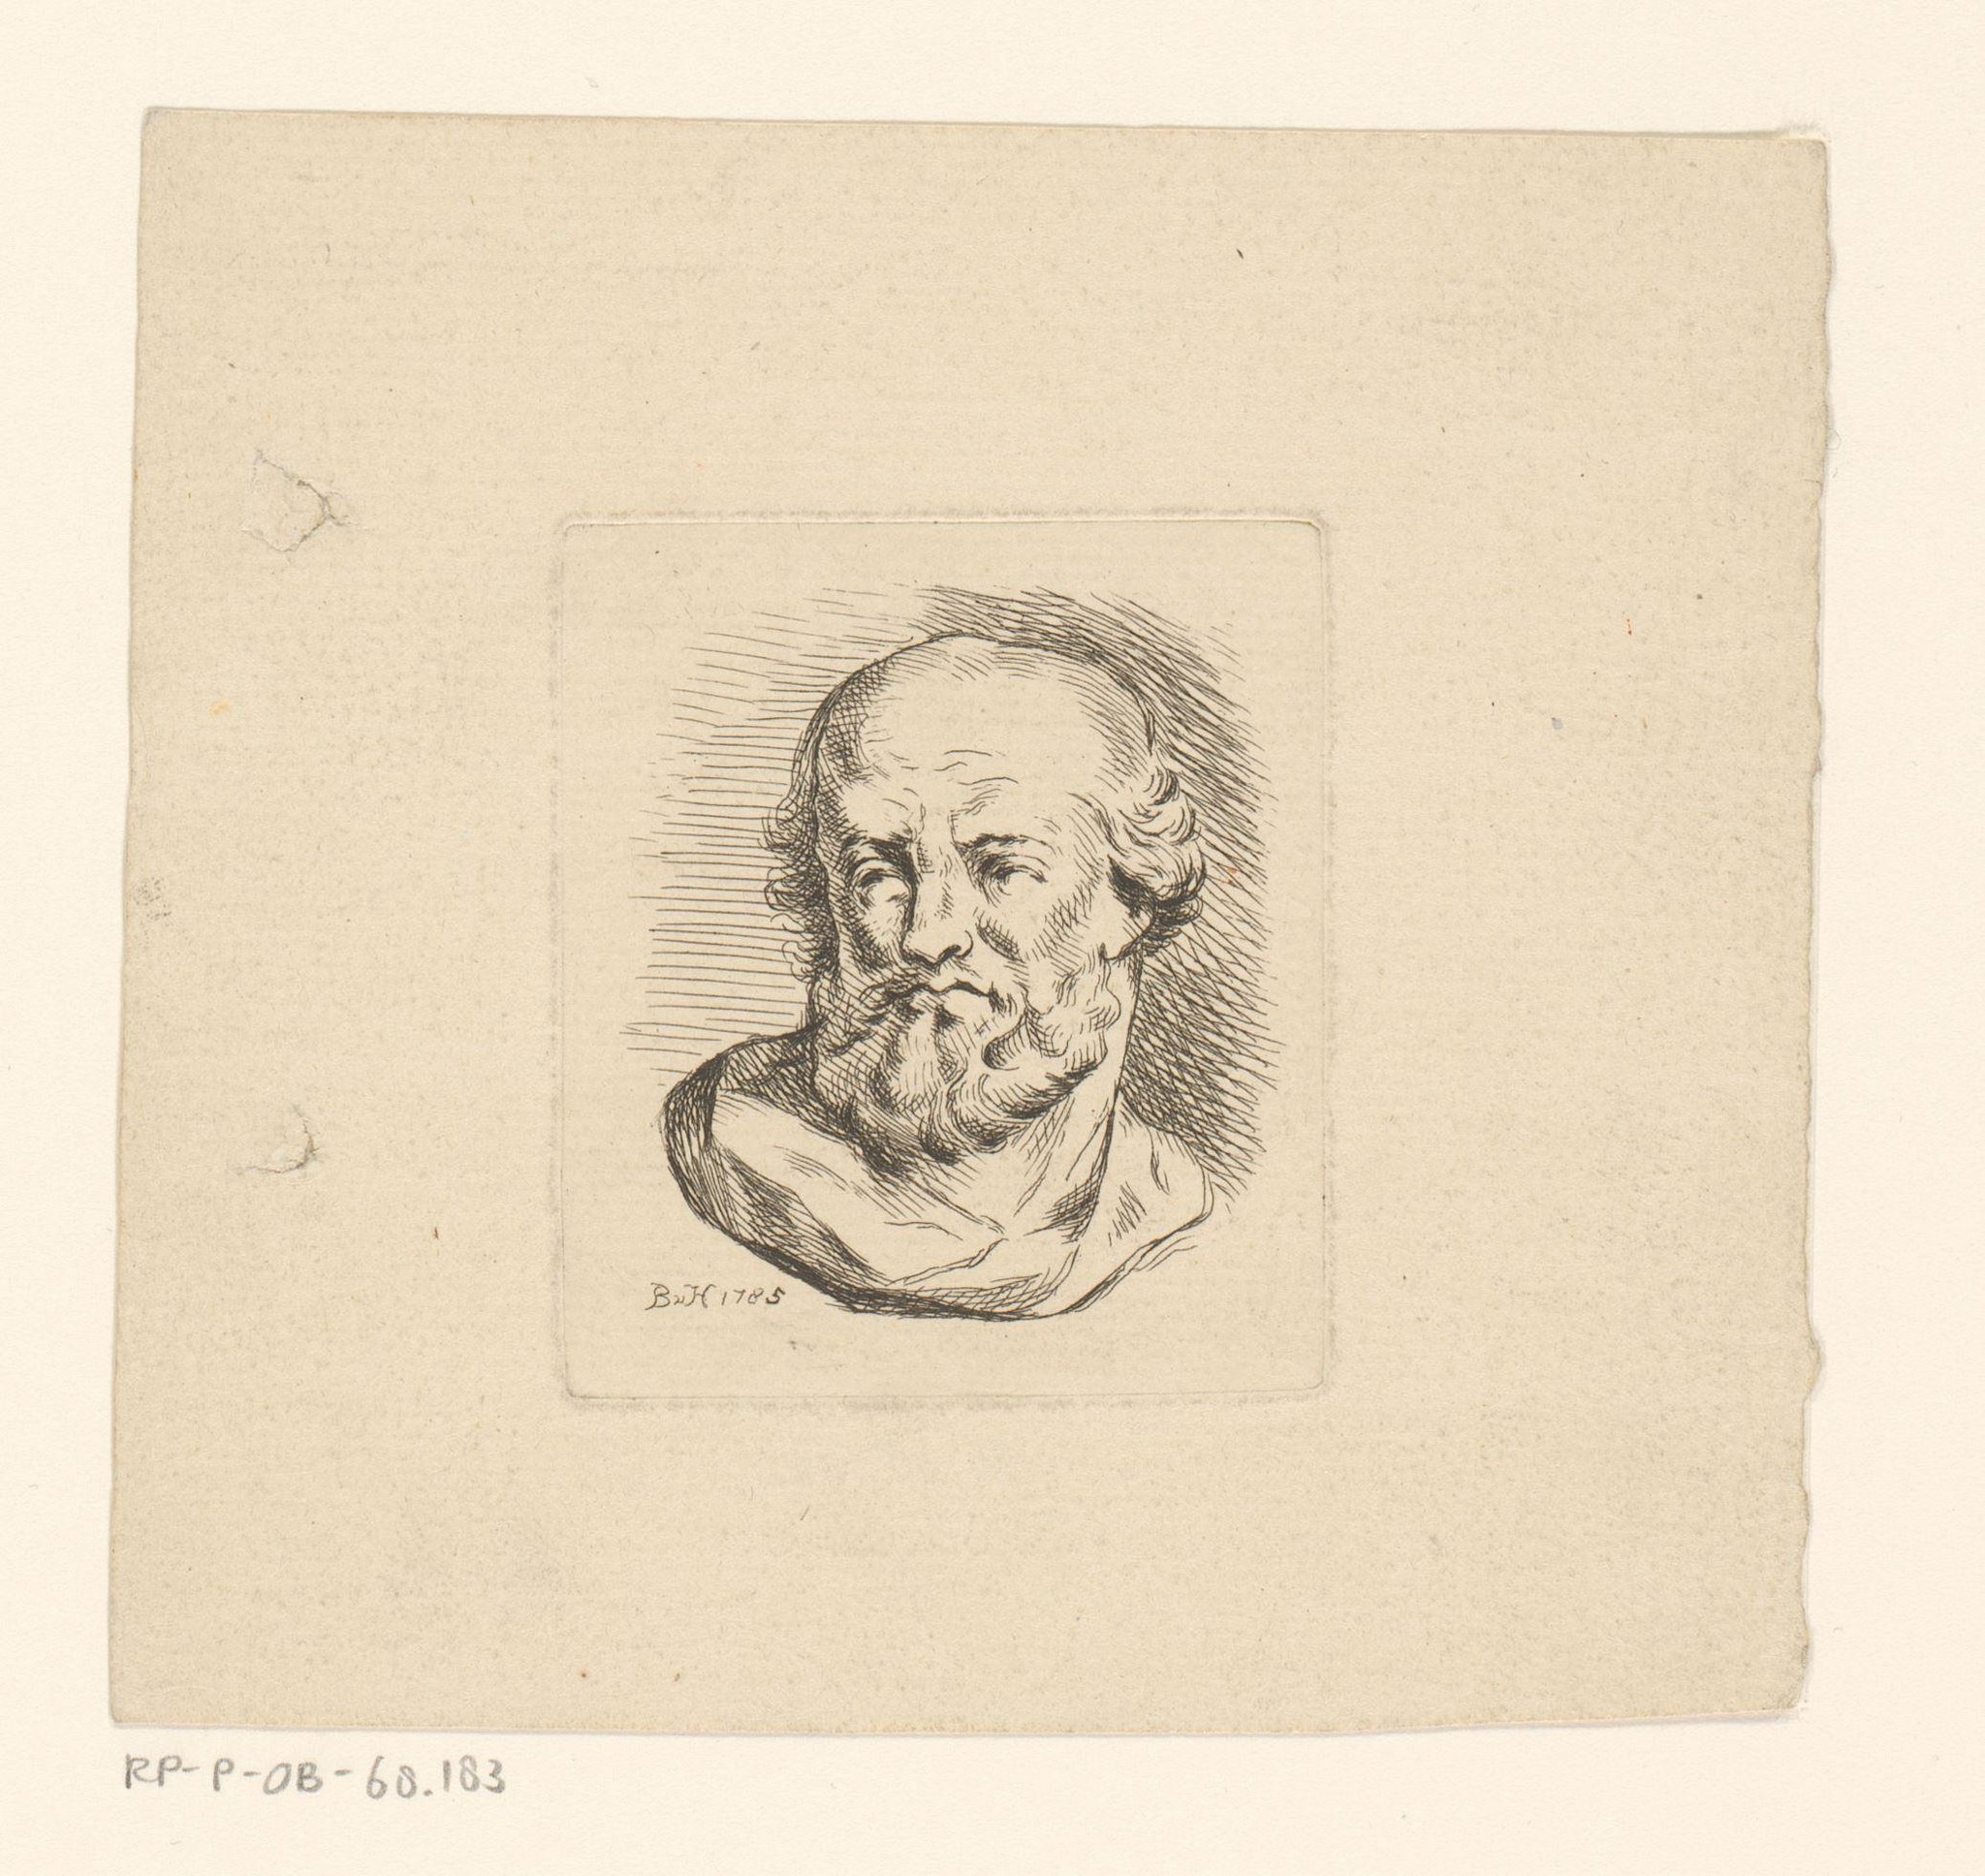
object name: print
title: Portret van een onbekende man met baard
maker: monogrammist bvh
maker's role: print maker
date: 1785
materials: paper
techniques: etching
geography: low countries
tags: anonymous historical person portrayed alone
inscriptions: collector's mark: Lugt 2228